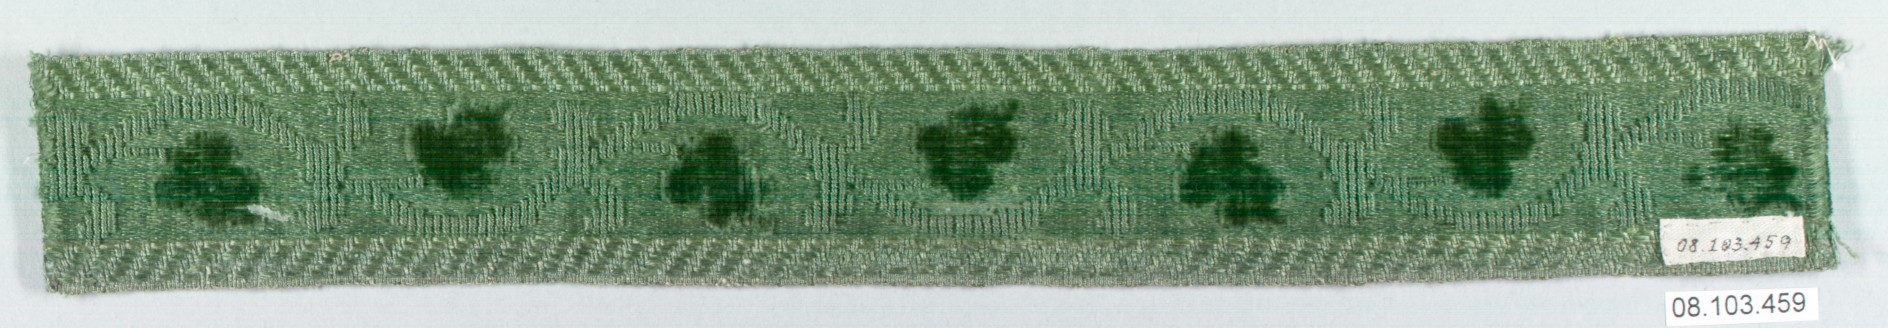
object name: galloon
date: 1801-1833